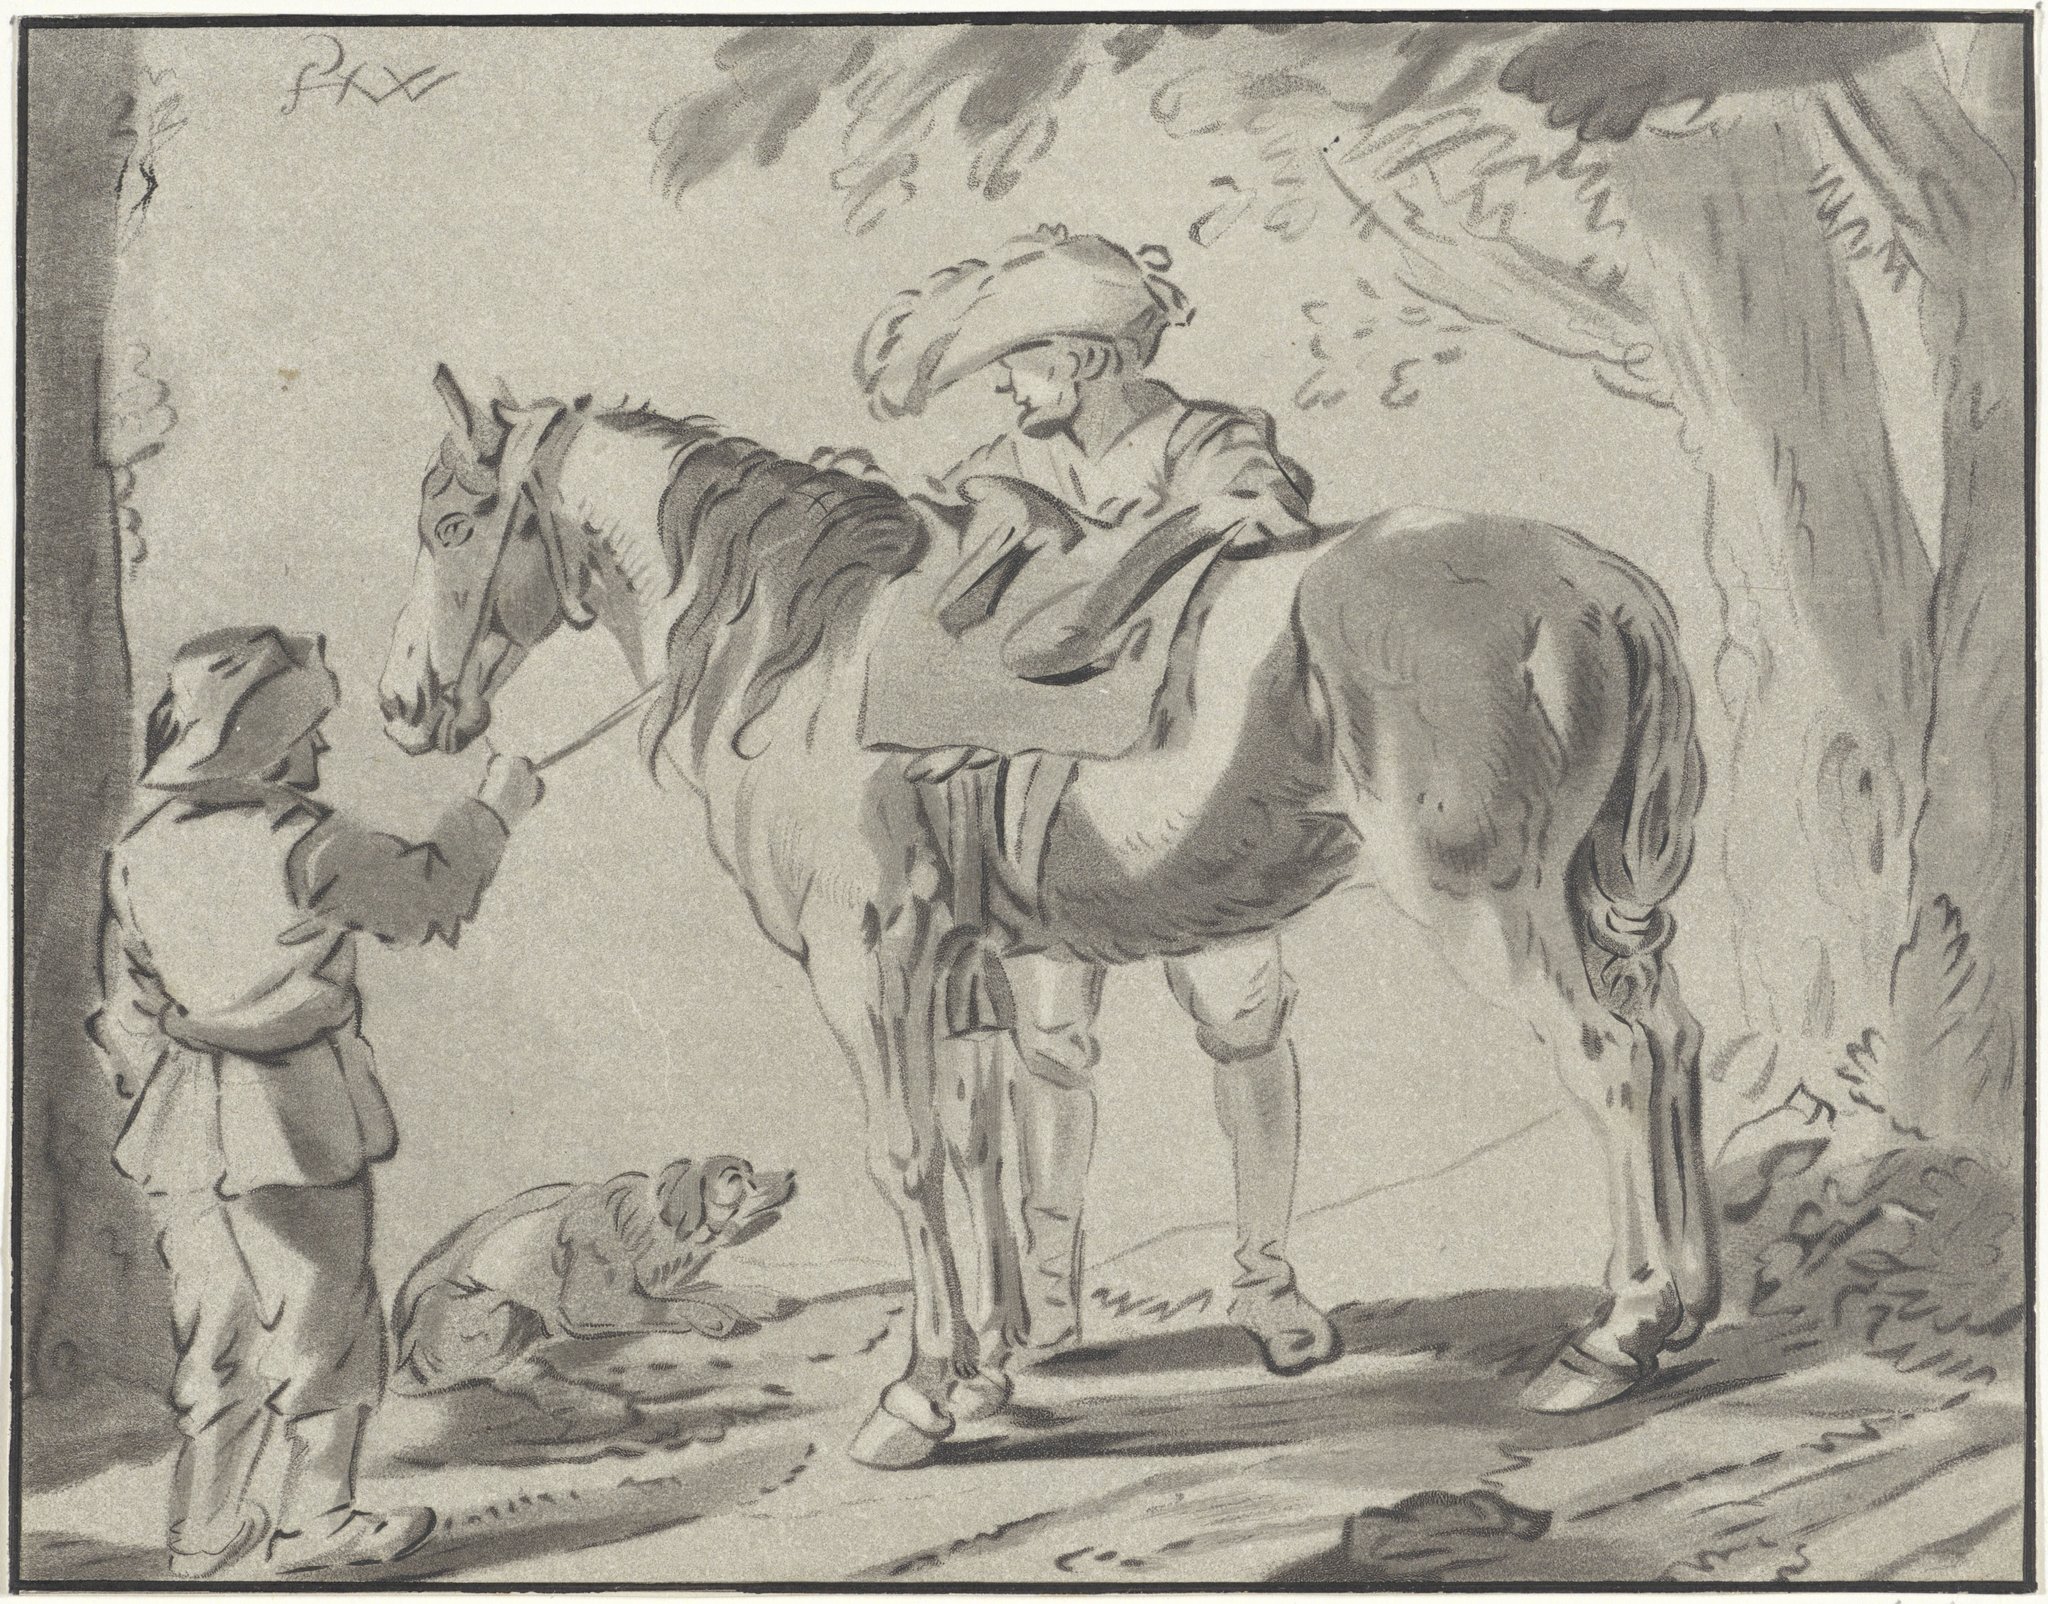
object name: print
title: Twee mannen bij een paard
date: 1767-1780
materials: paper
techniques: printmaking, rocker stamped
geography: netherlands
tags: horse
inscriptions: collector's mark: Lugt 2228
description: Een man houdt een paard bij de teugel vast, terwijl een andere man het paard zadelt. Bij hen een hond.